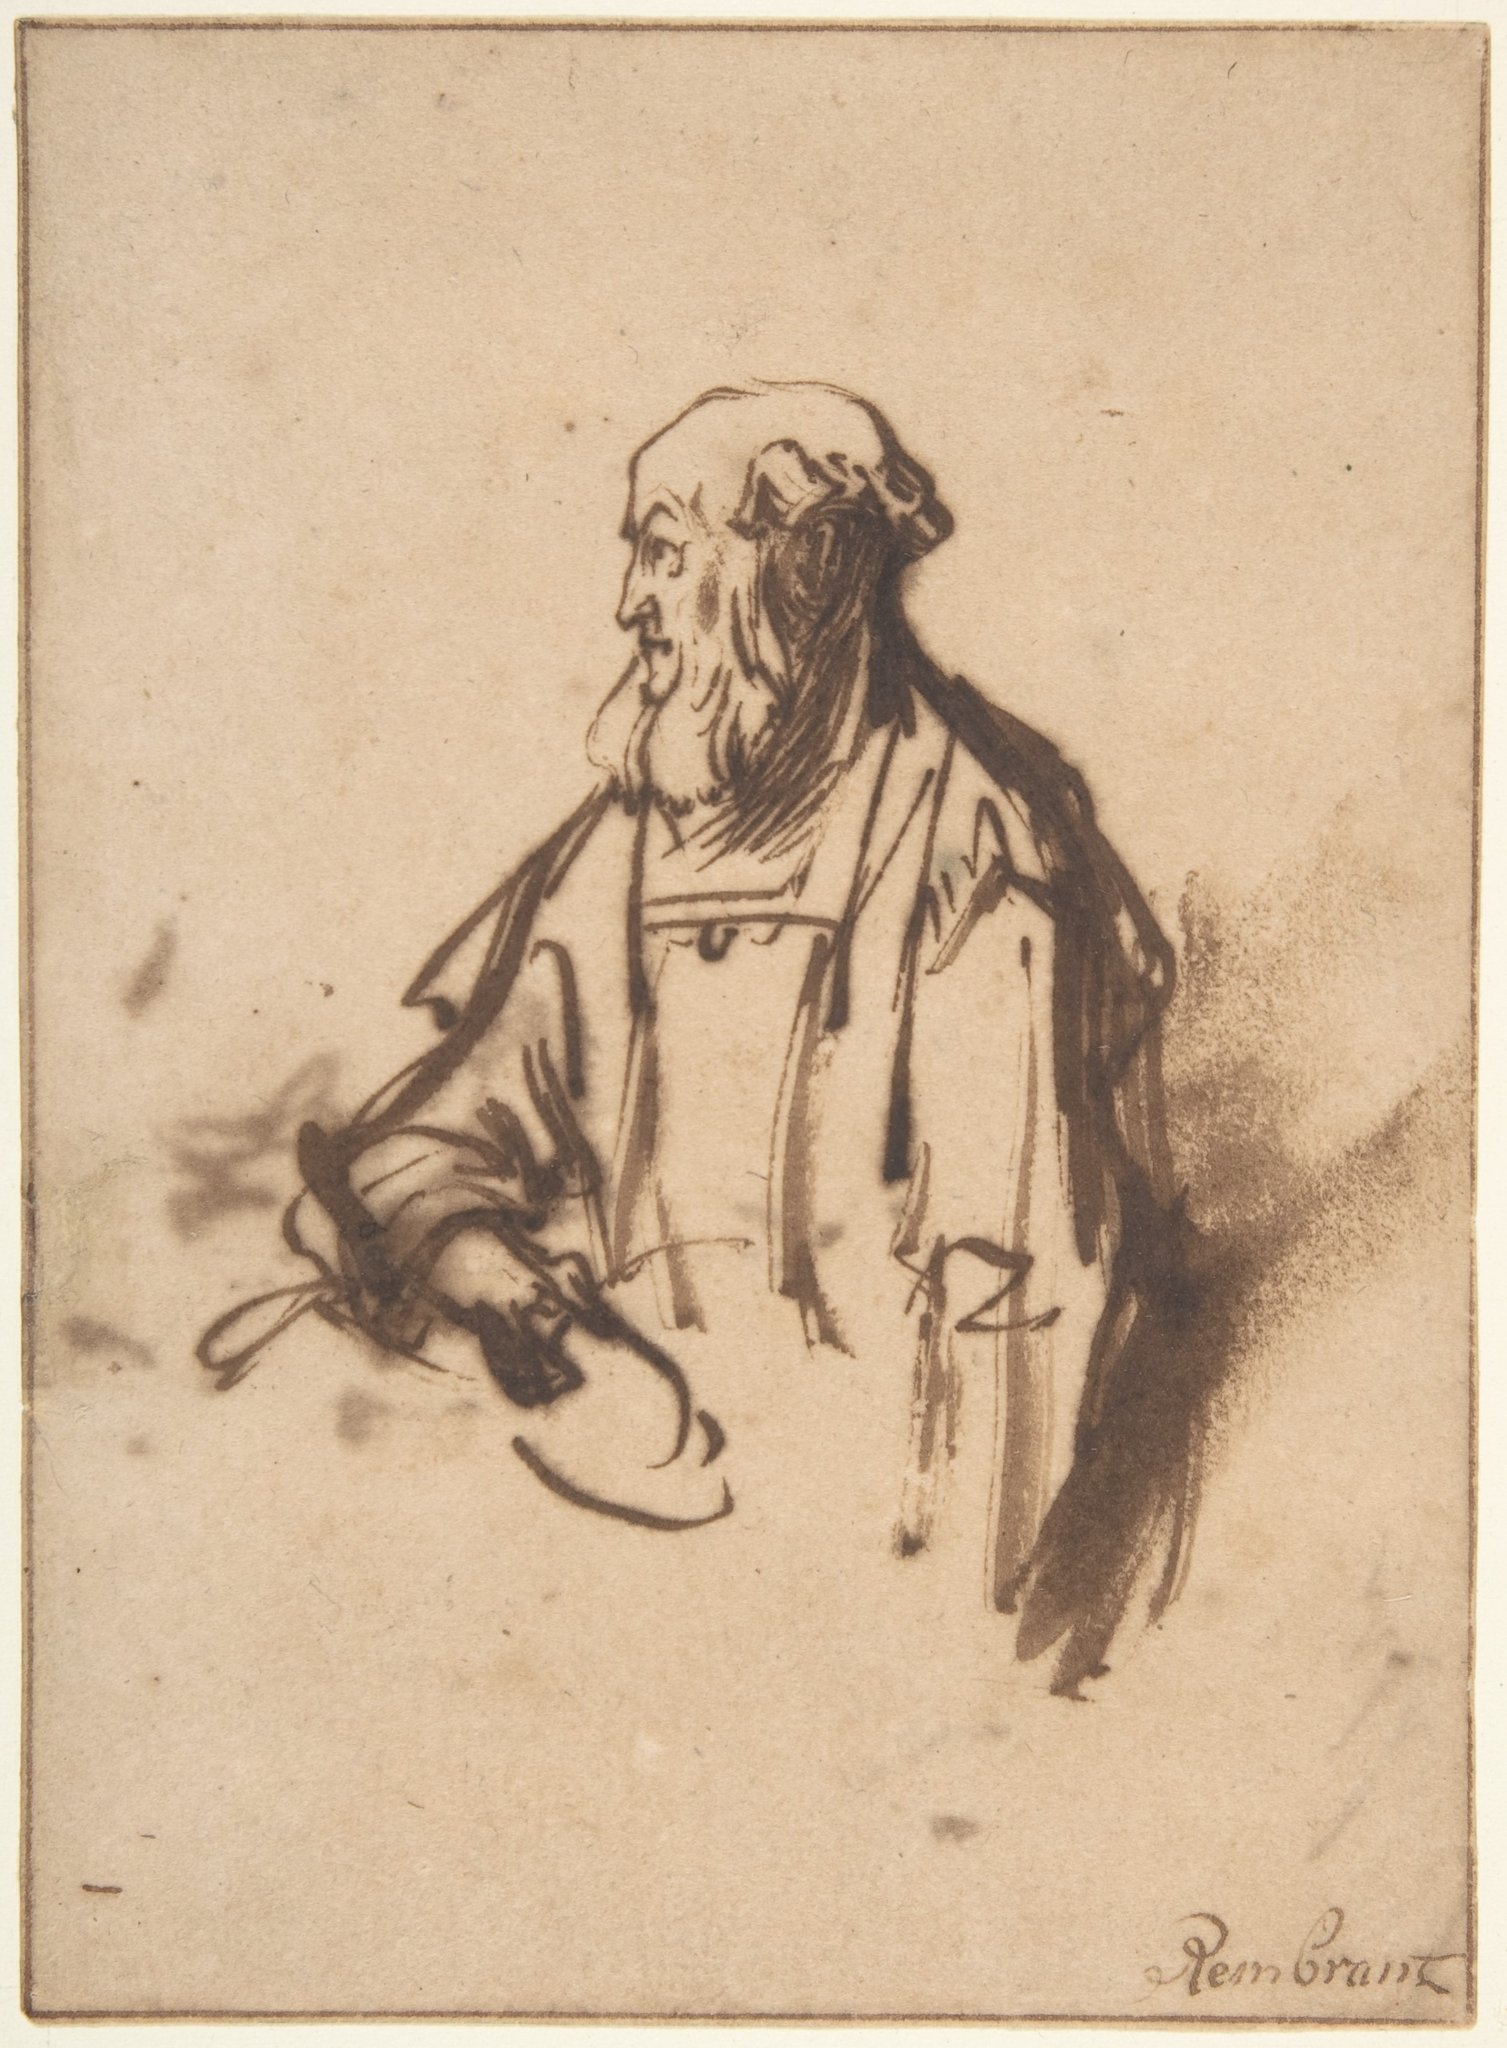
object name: drawing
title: Old Man in Profile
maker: rembrandt van rijn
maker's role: artist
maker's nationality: dutch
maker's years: 1606-1669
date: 1620-1669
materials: ink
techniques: brush, pen, wash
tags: men,profiles